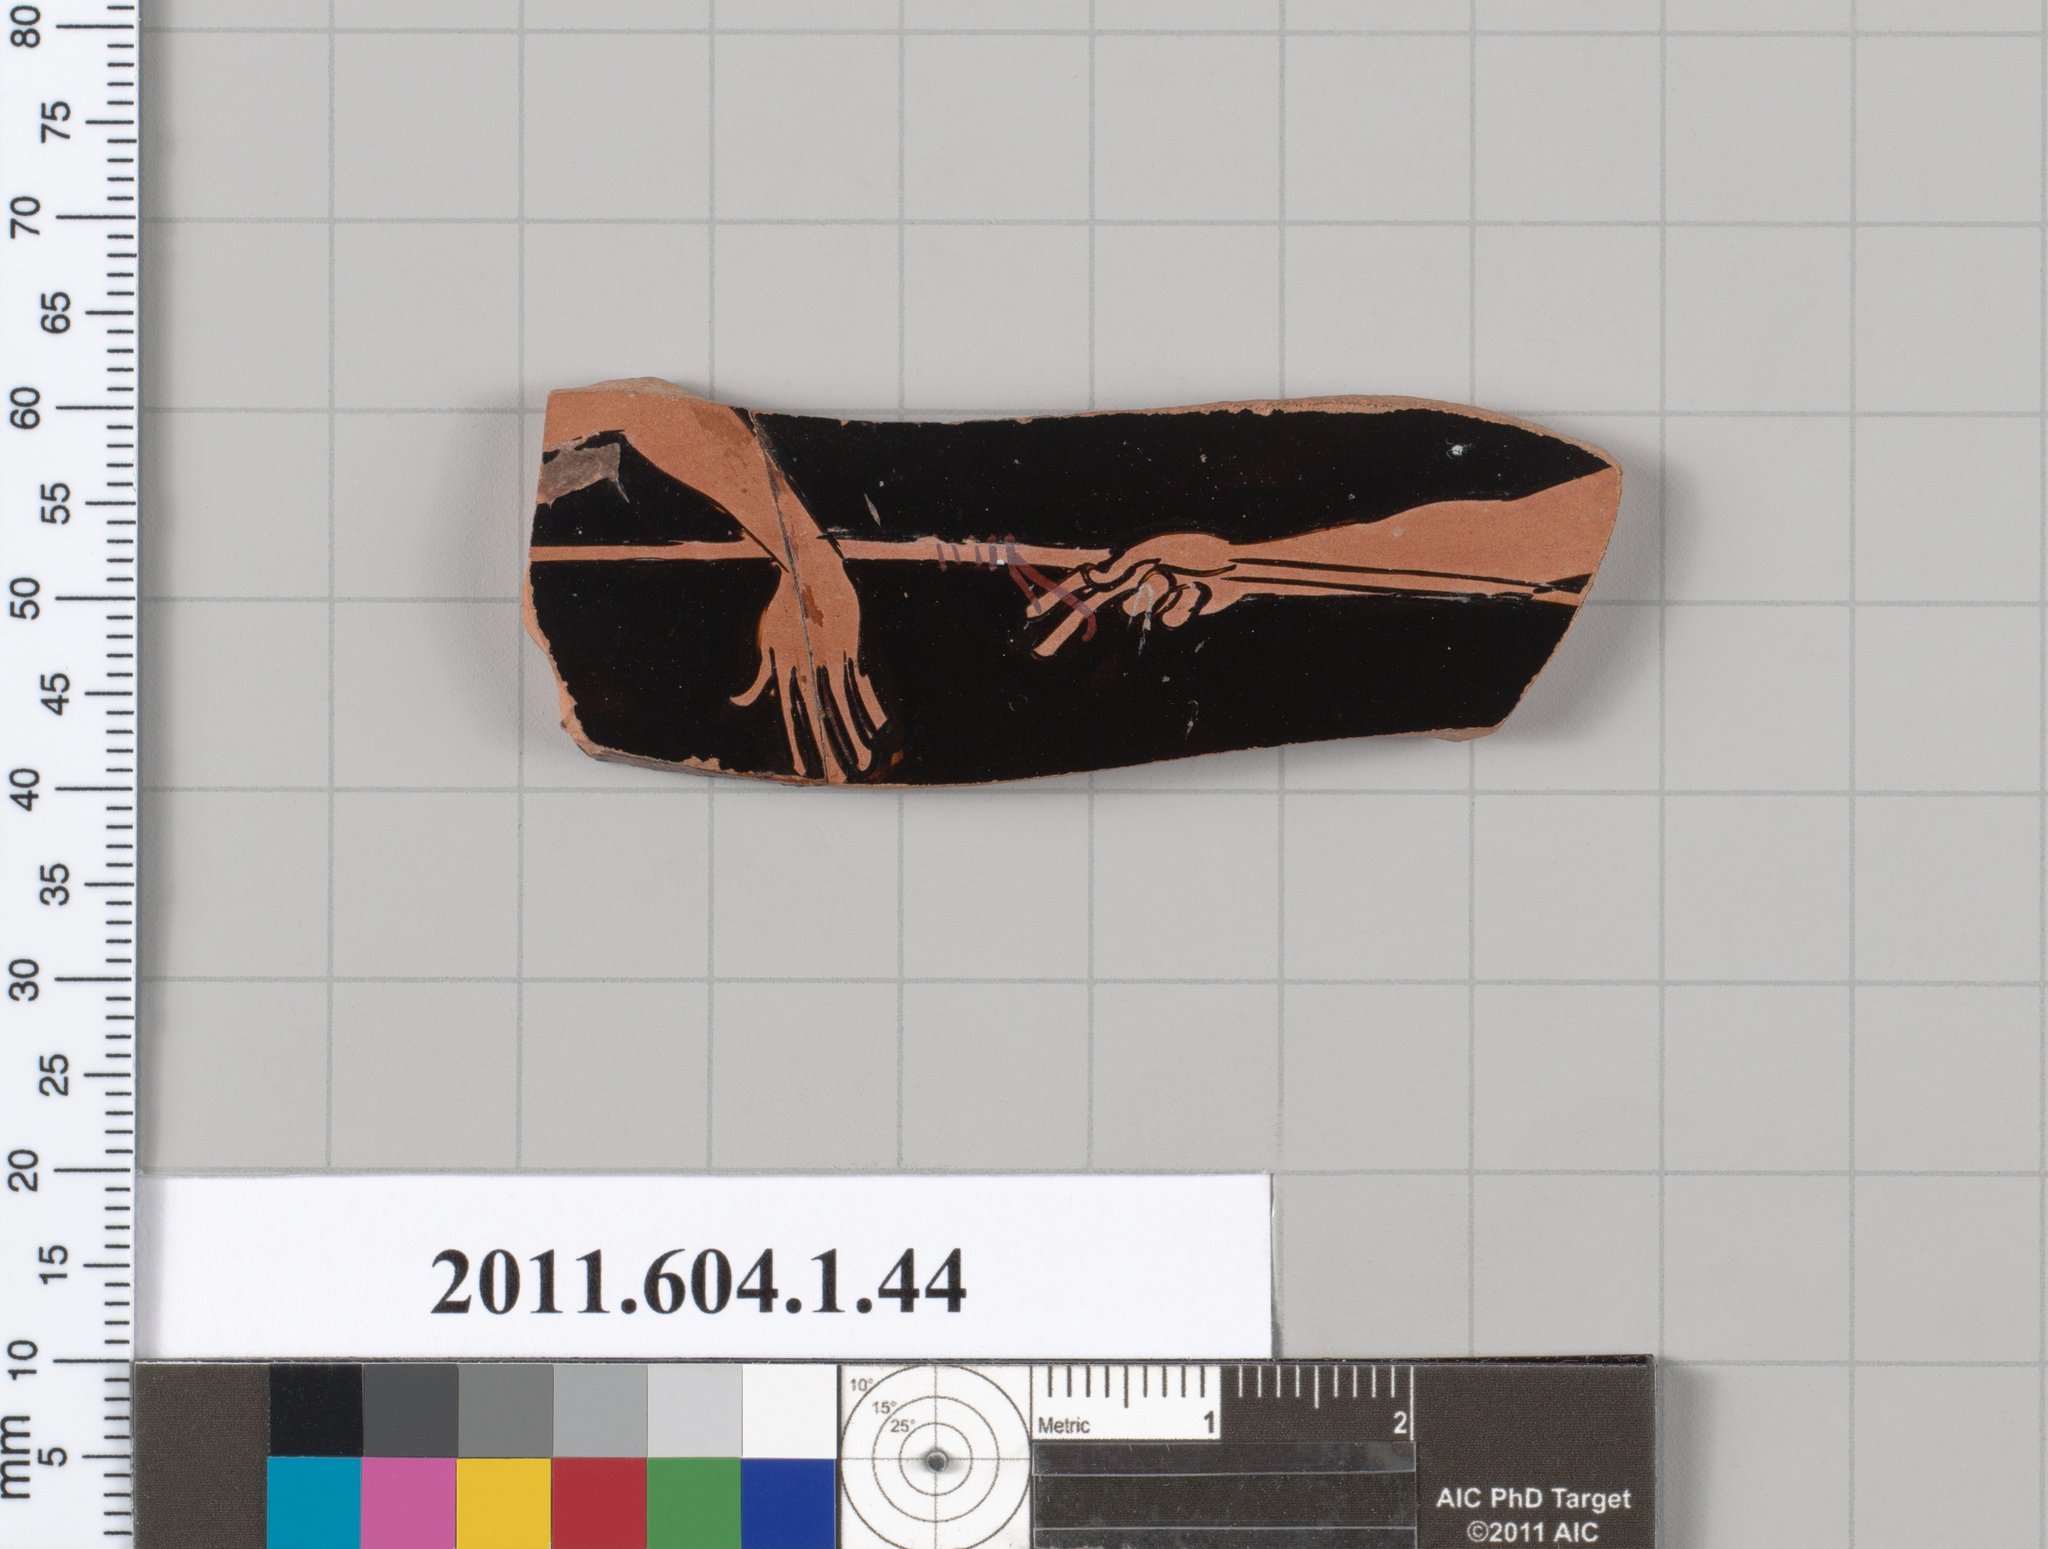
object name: kylix fragment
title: Terracotta fragment of a kylix (drinking cup)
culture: greek, attic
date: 490-480 BCE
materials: terracotta